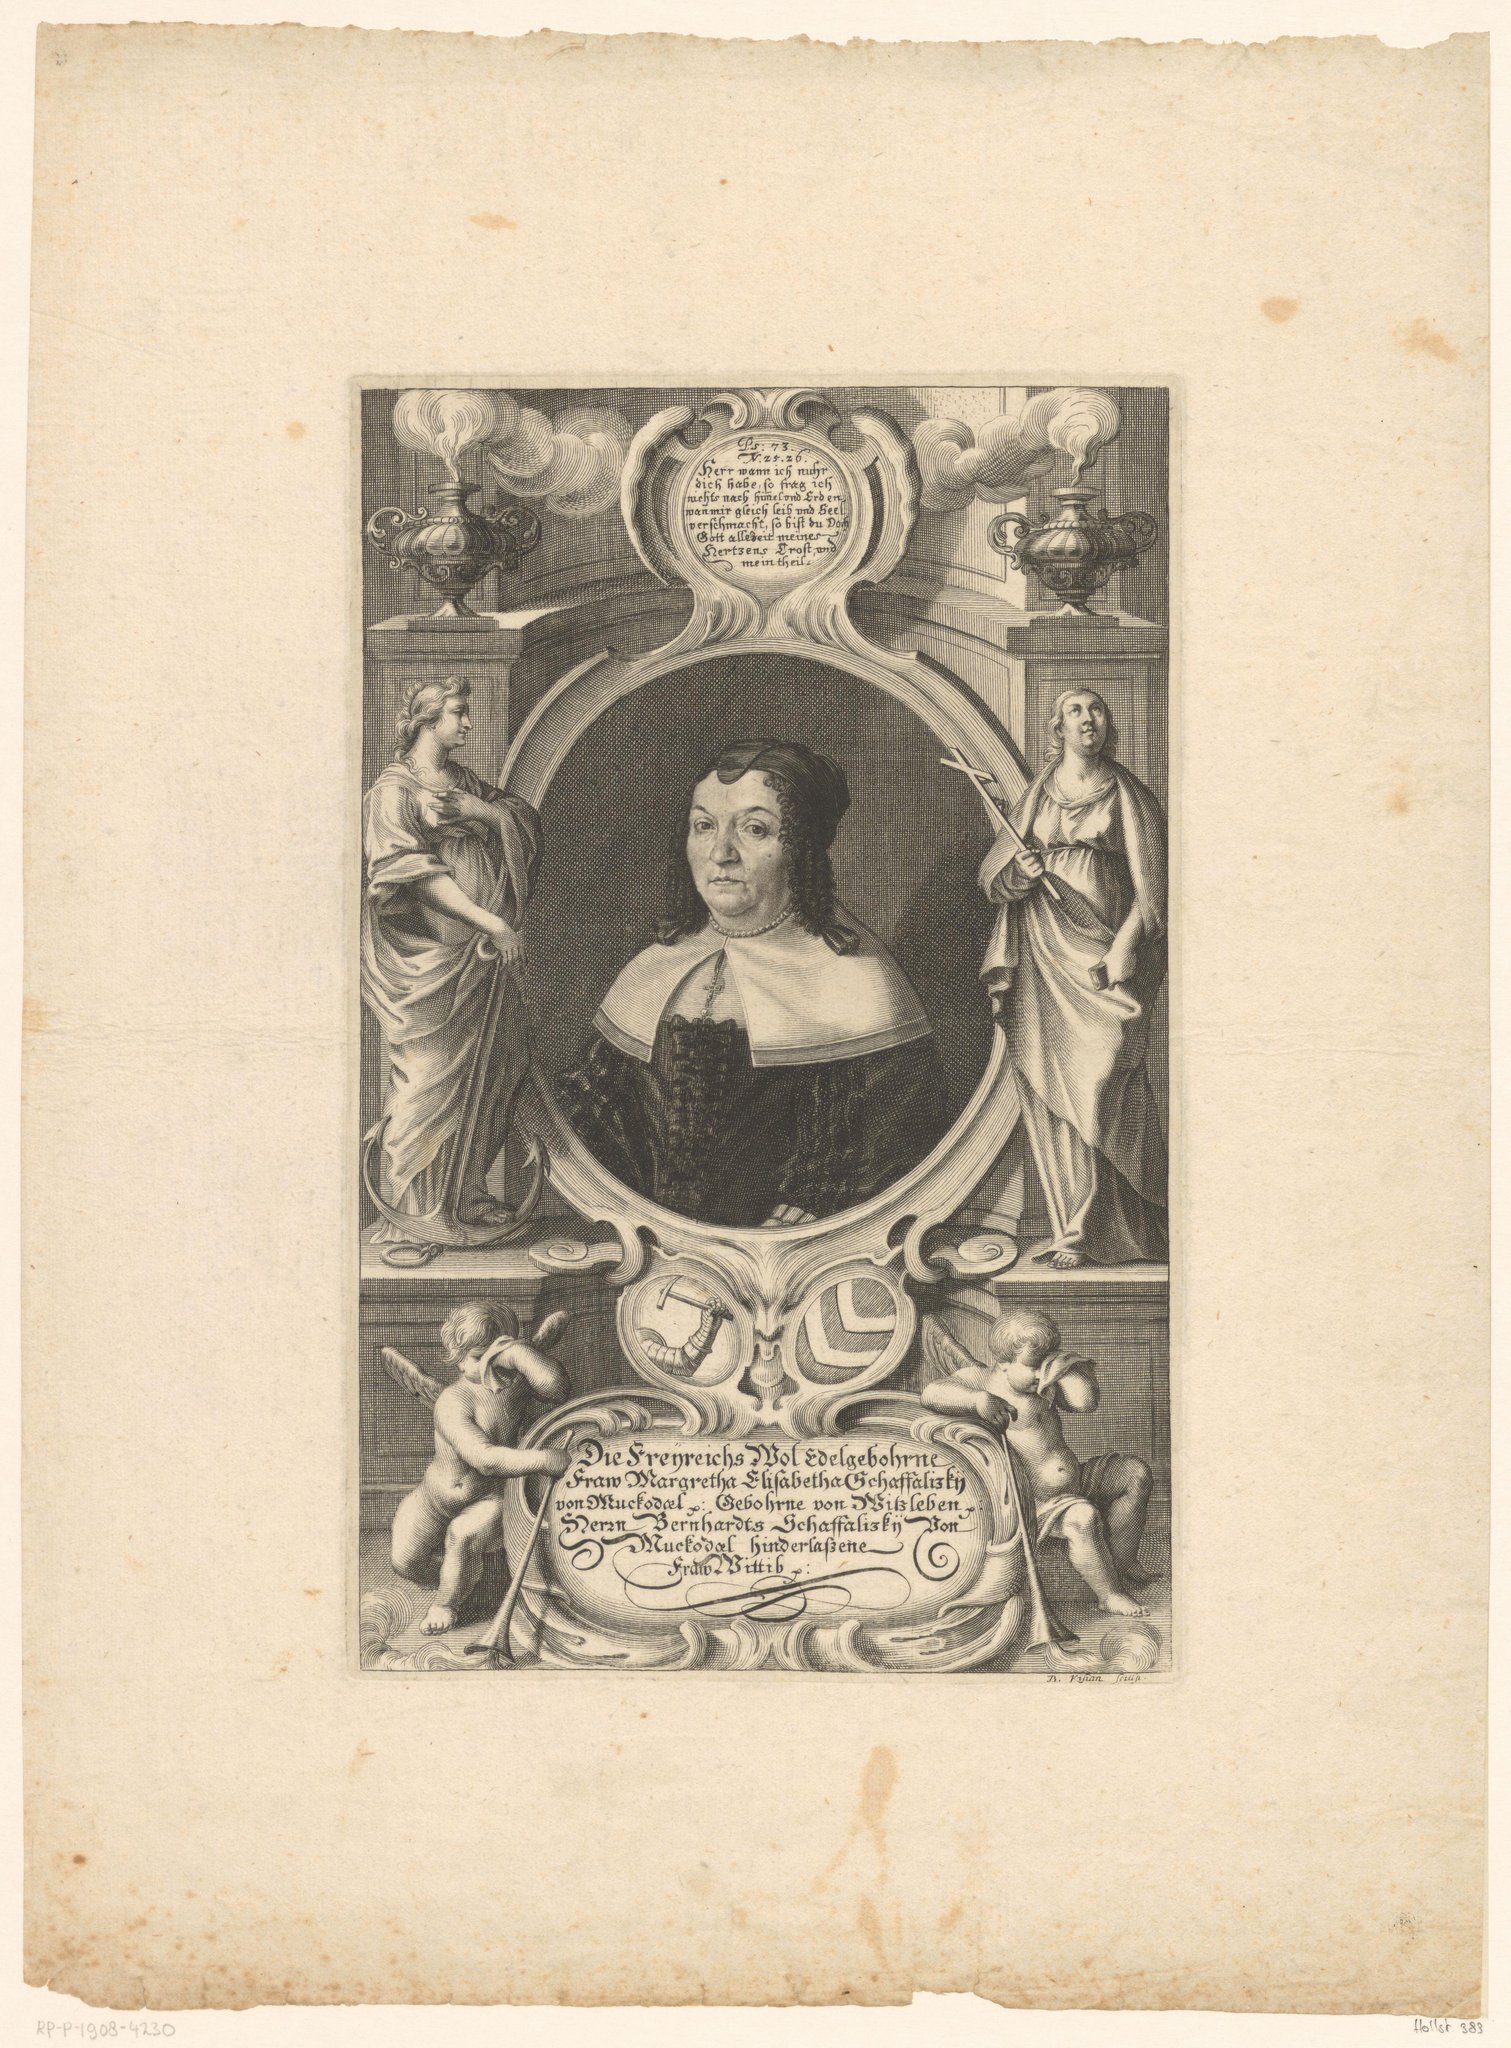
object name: print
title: Portret van Margaretha Elisabetha Schaffalitzki von Mukodell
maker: bartholomäus kilian (ii)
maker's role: artist, draughtsman, print maker, publisher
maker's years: 1630-1696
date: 1661-1696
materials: paper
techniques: engraving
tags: historical persons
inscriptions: collector's mark: Lugt 2228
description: Tekst in het Duits in de cartouche en Psalm 73:25-26 bovenaan.